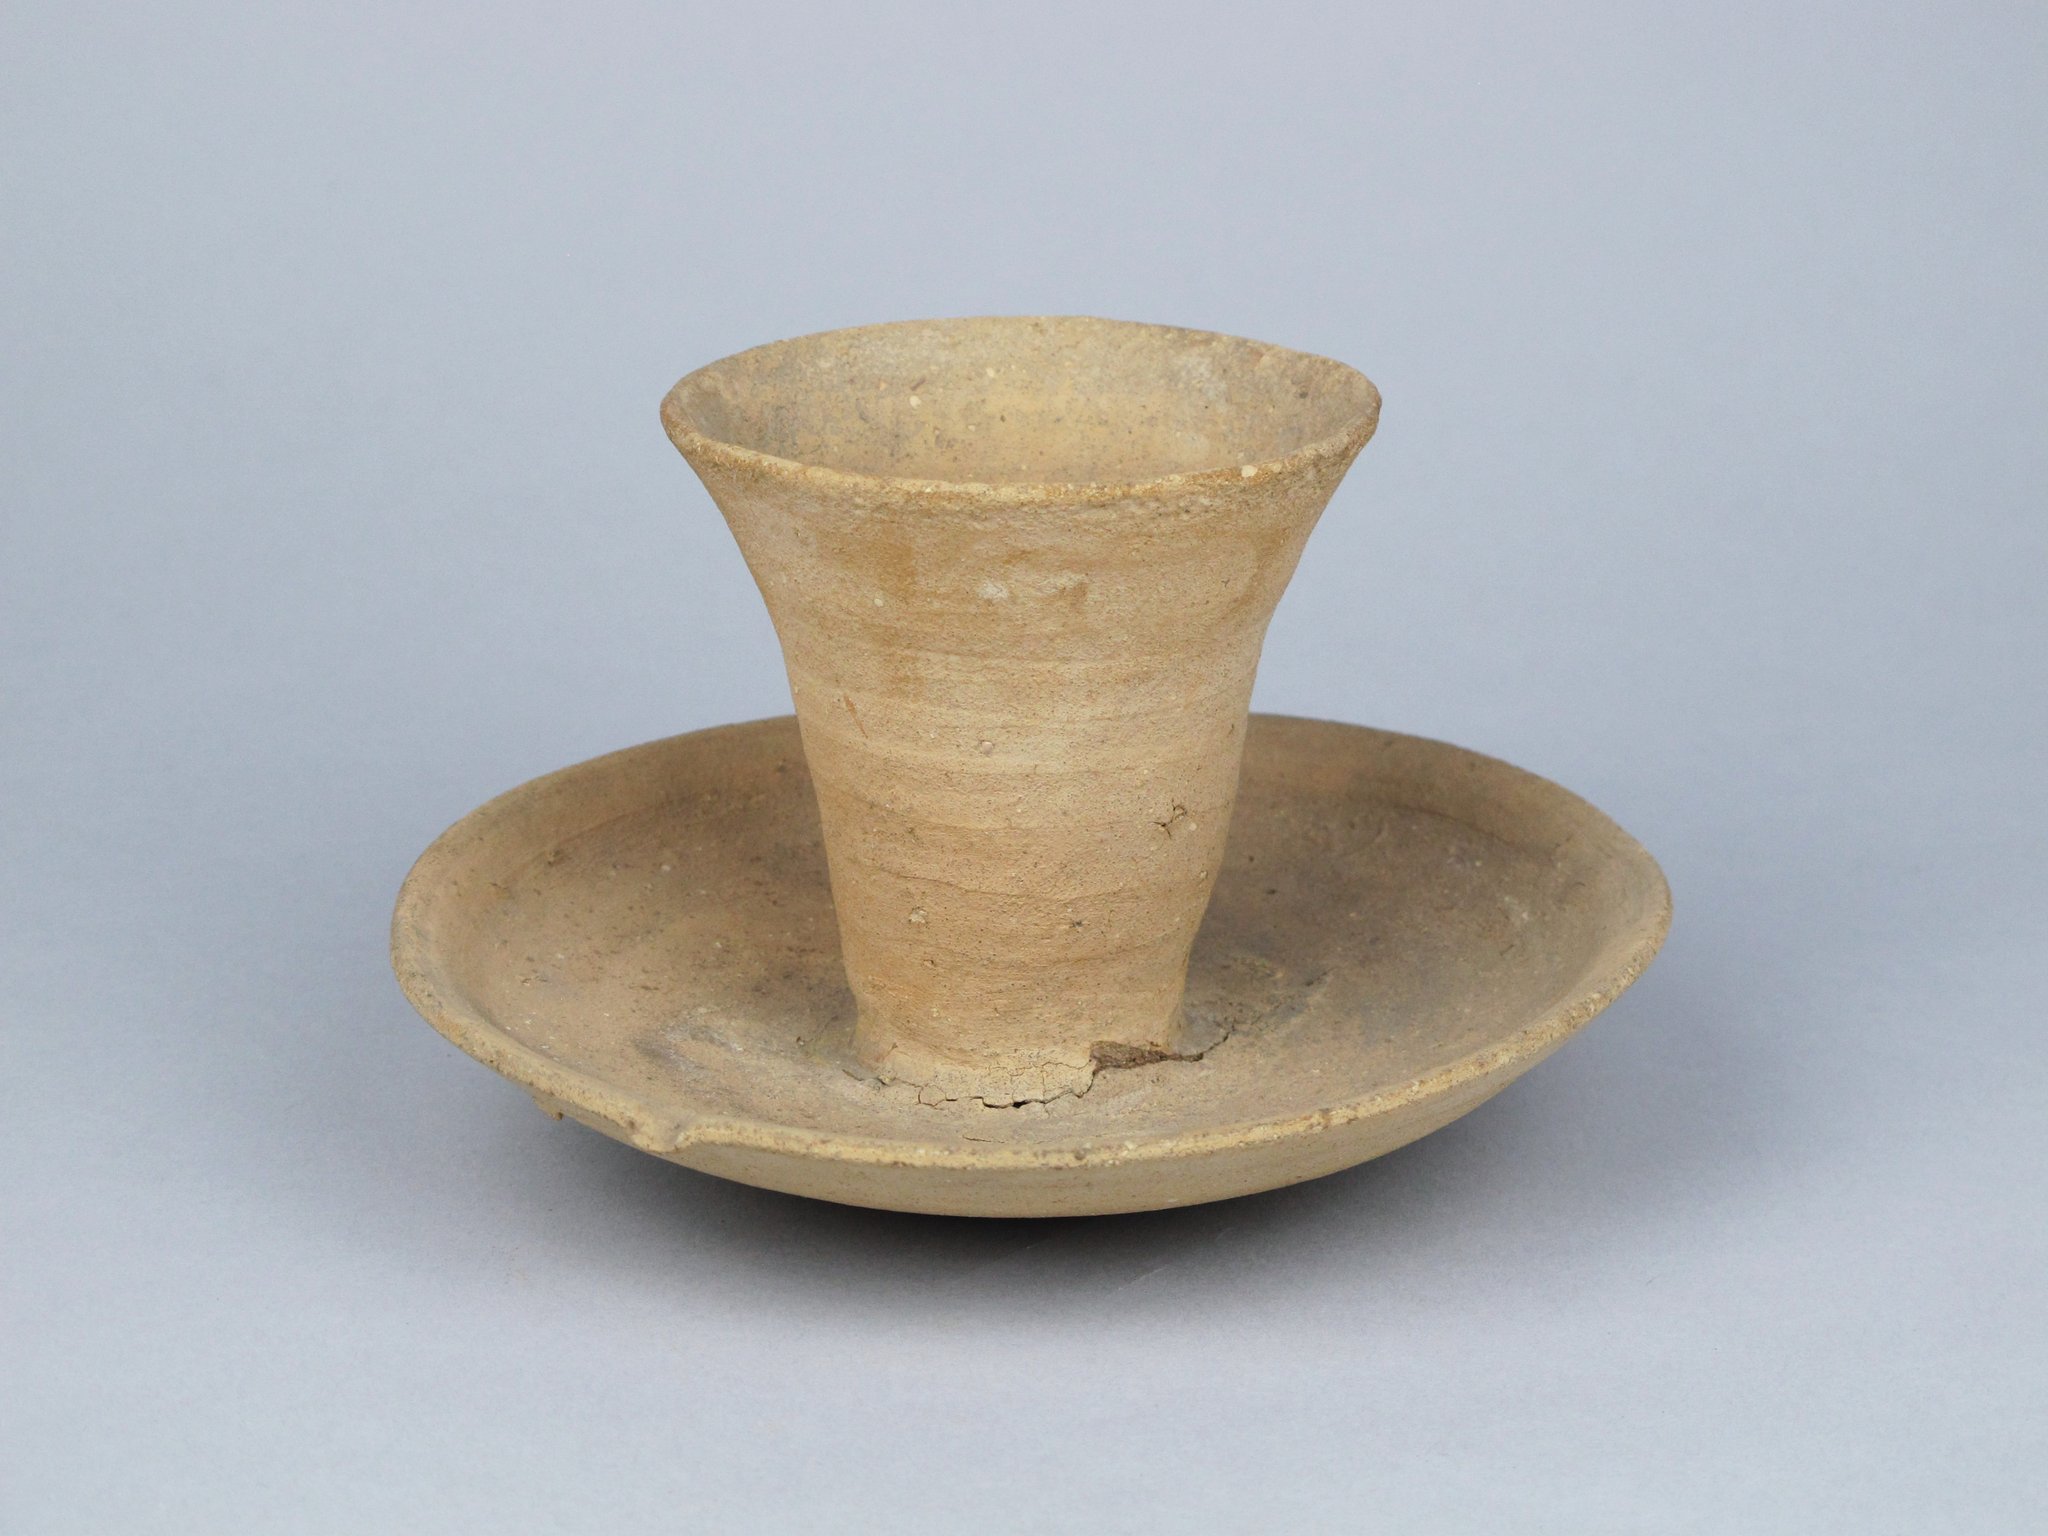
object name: torch holder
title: Torch-holder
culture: cypriot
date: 600-301 BCE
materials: terracotta